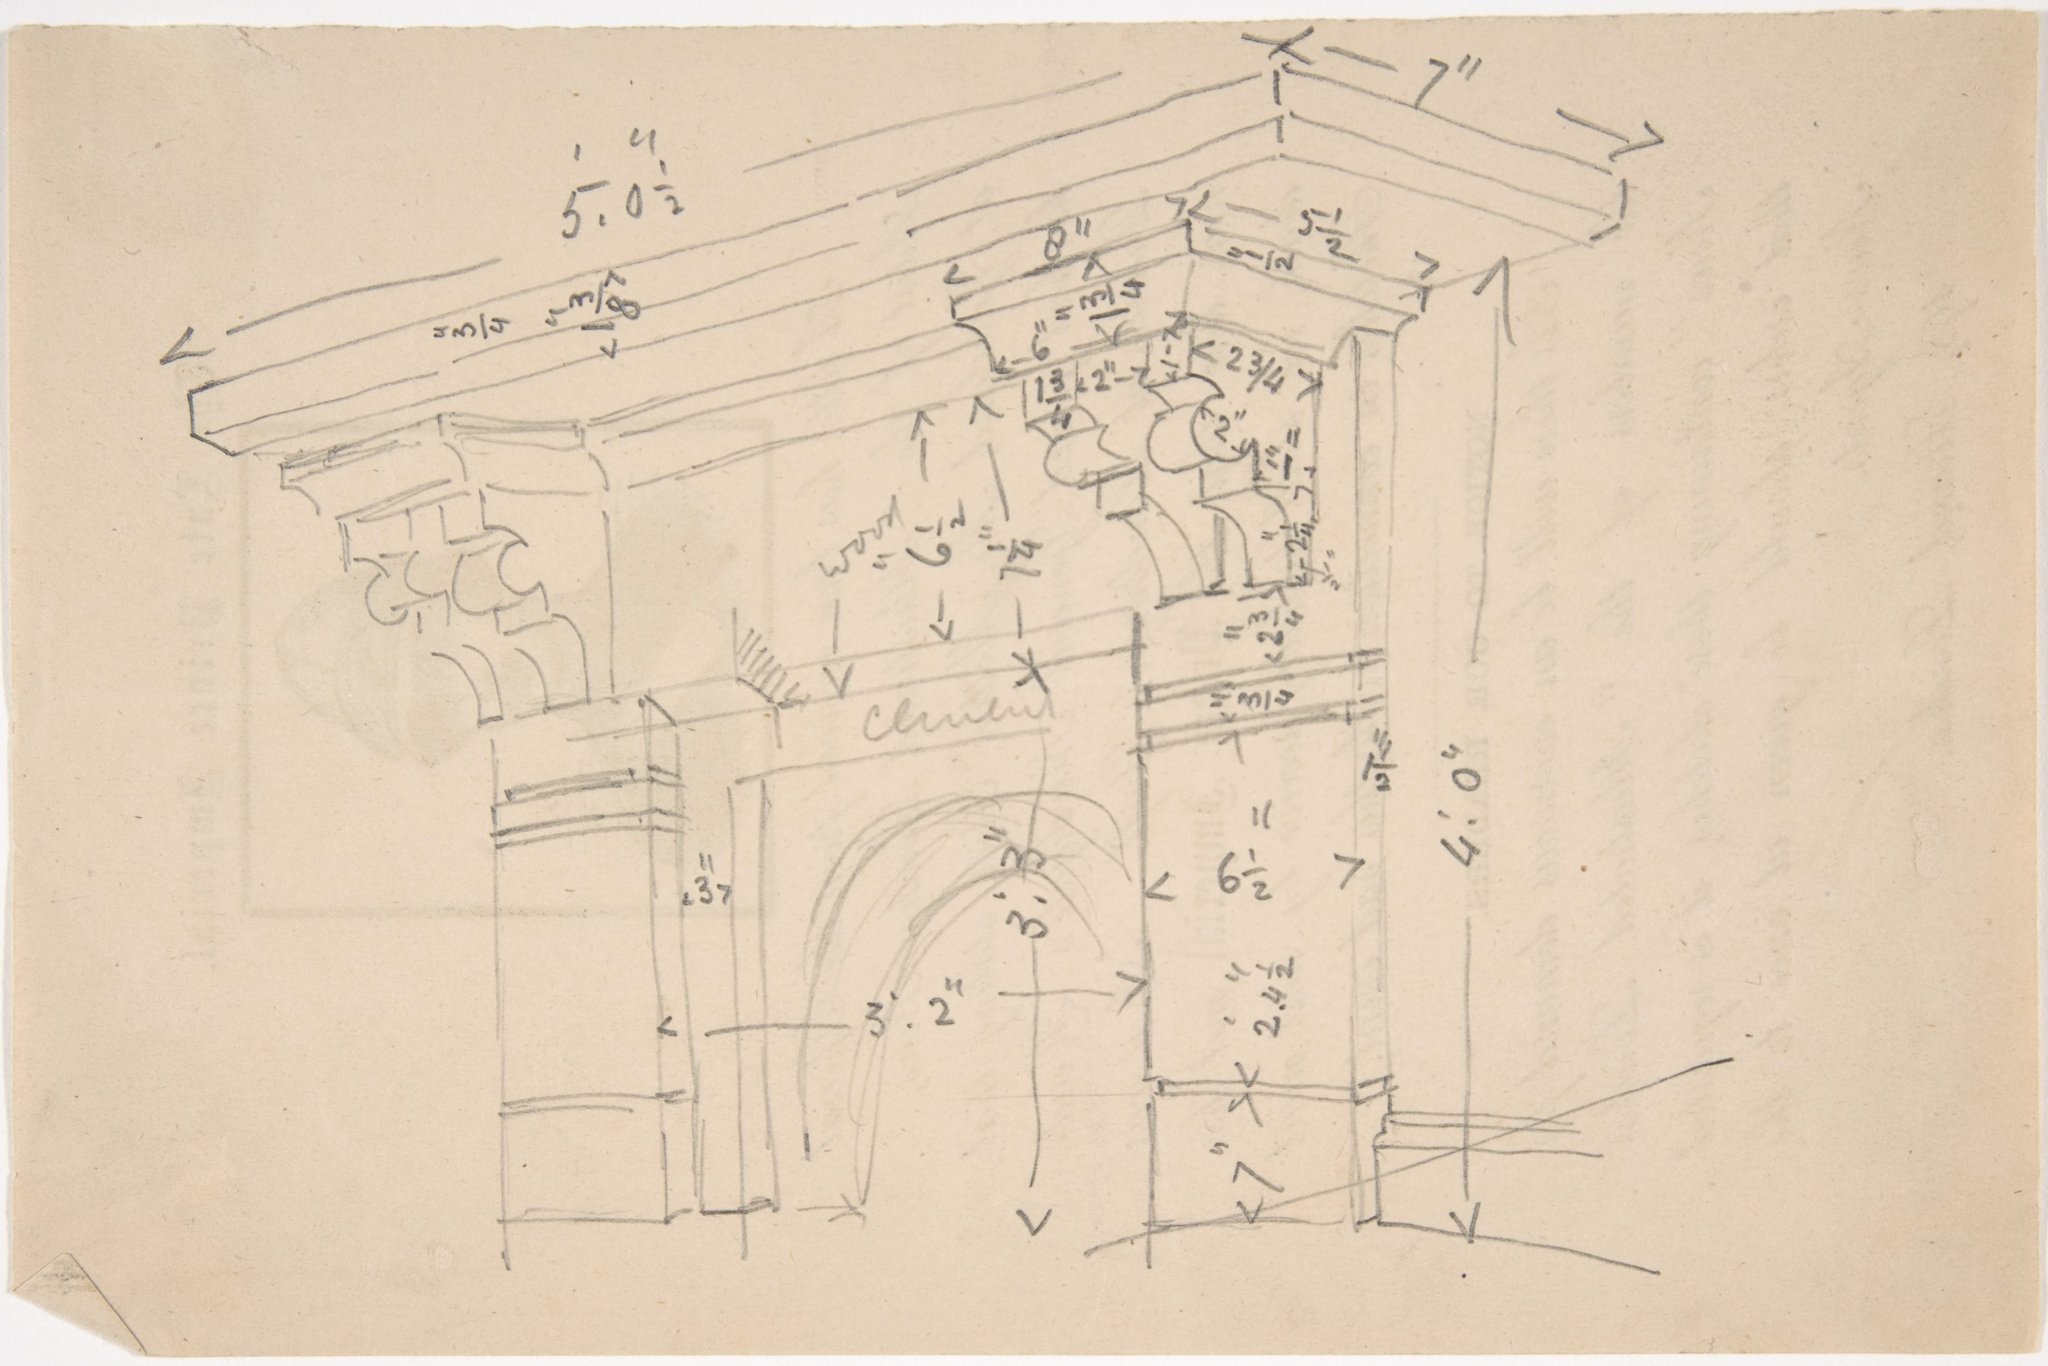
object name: drawing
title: Measured Drawing of Cornice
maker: anonymous, british, 19th century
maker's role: artist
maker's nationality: british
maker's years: 1800-1900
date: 1801-1900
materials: graphite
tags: architecture